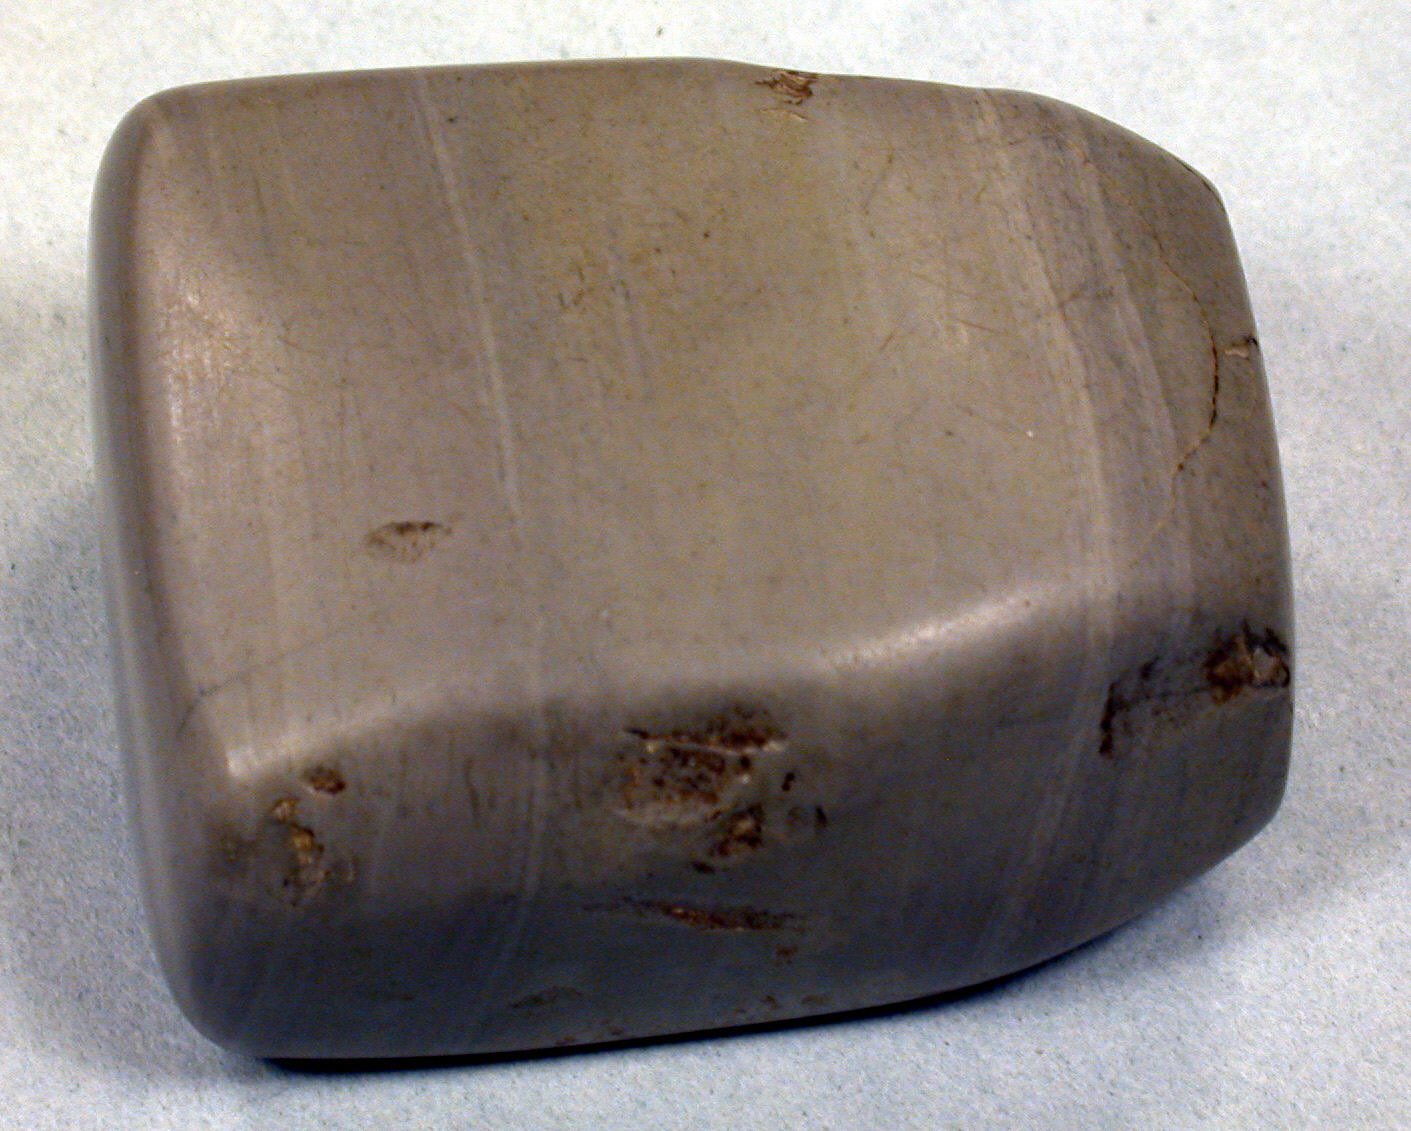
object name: ritual stone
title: Pulidor (polishing stone) (?)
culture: peruvian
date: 1501-1600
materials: stone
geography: peru